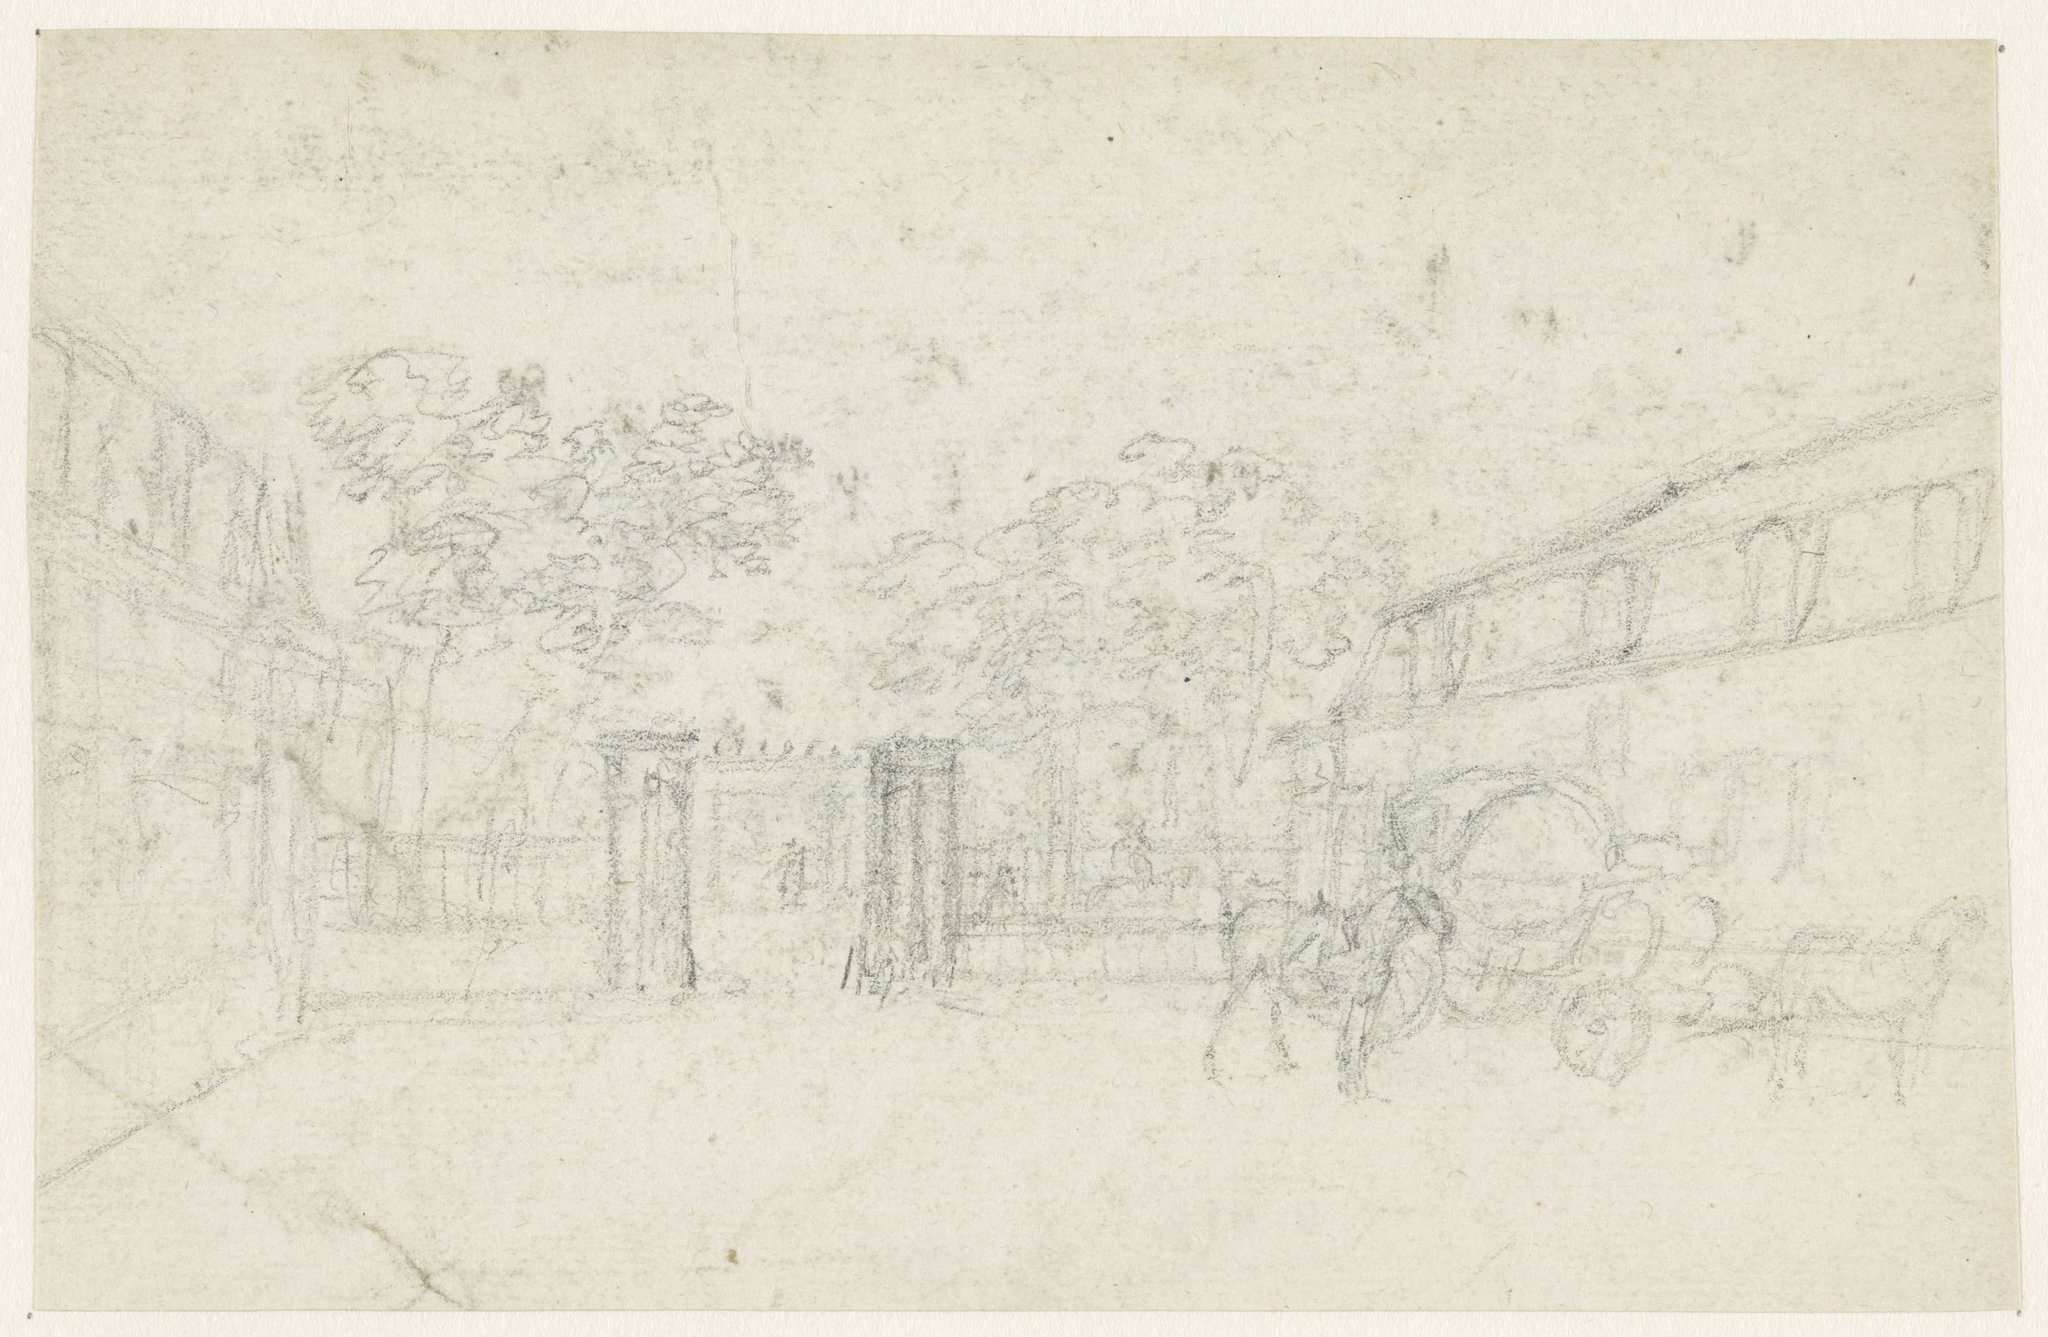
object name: drawing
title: Postkoets bij een hek tussen twee gebouwen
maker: georges michel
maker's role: draughtsman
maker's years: 1763-1843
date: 1773-1843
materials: paper, pencil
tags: public road (+ city(-scape) with figures, staffage)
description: Een van 120 tekeningen, afkomstig uit een 19e eeuws album met tekeningen van Georges Michel.